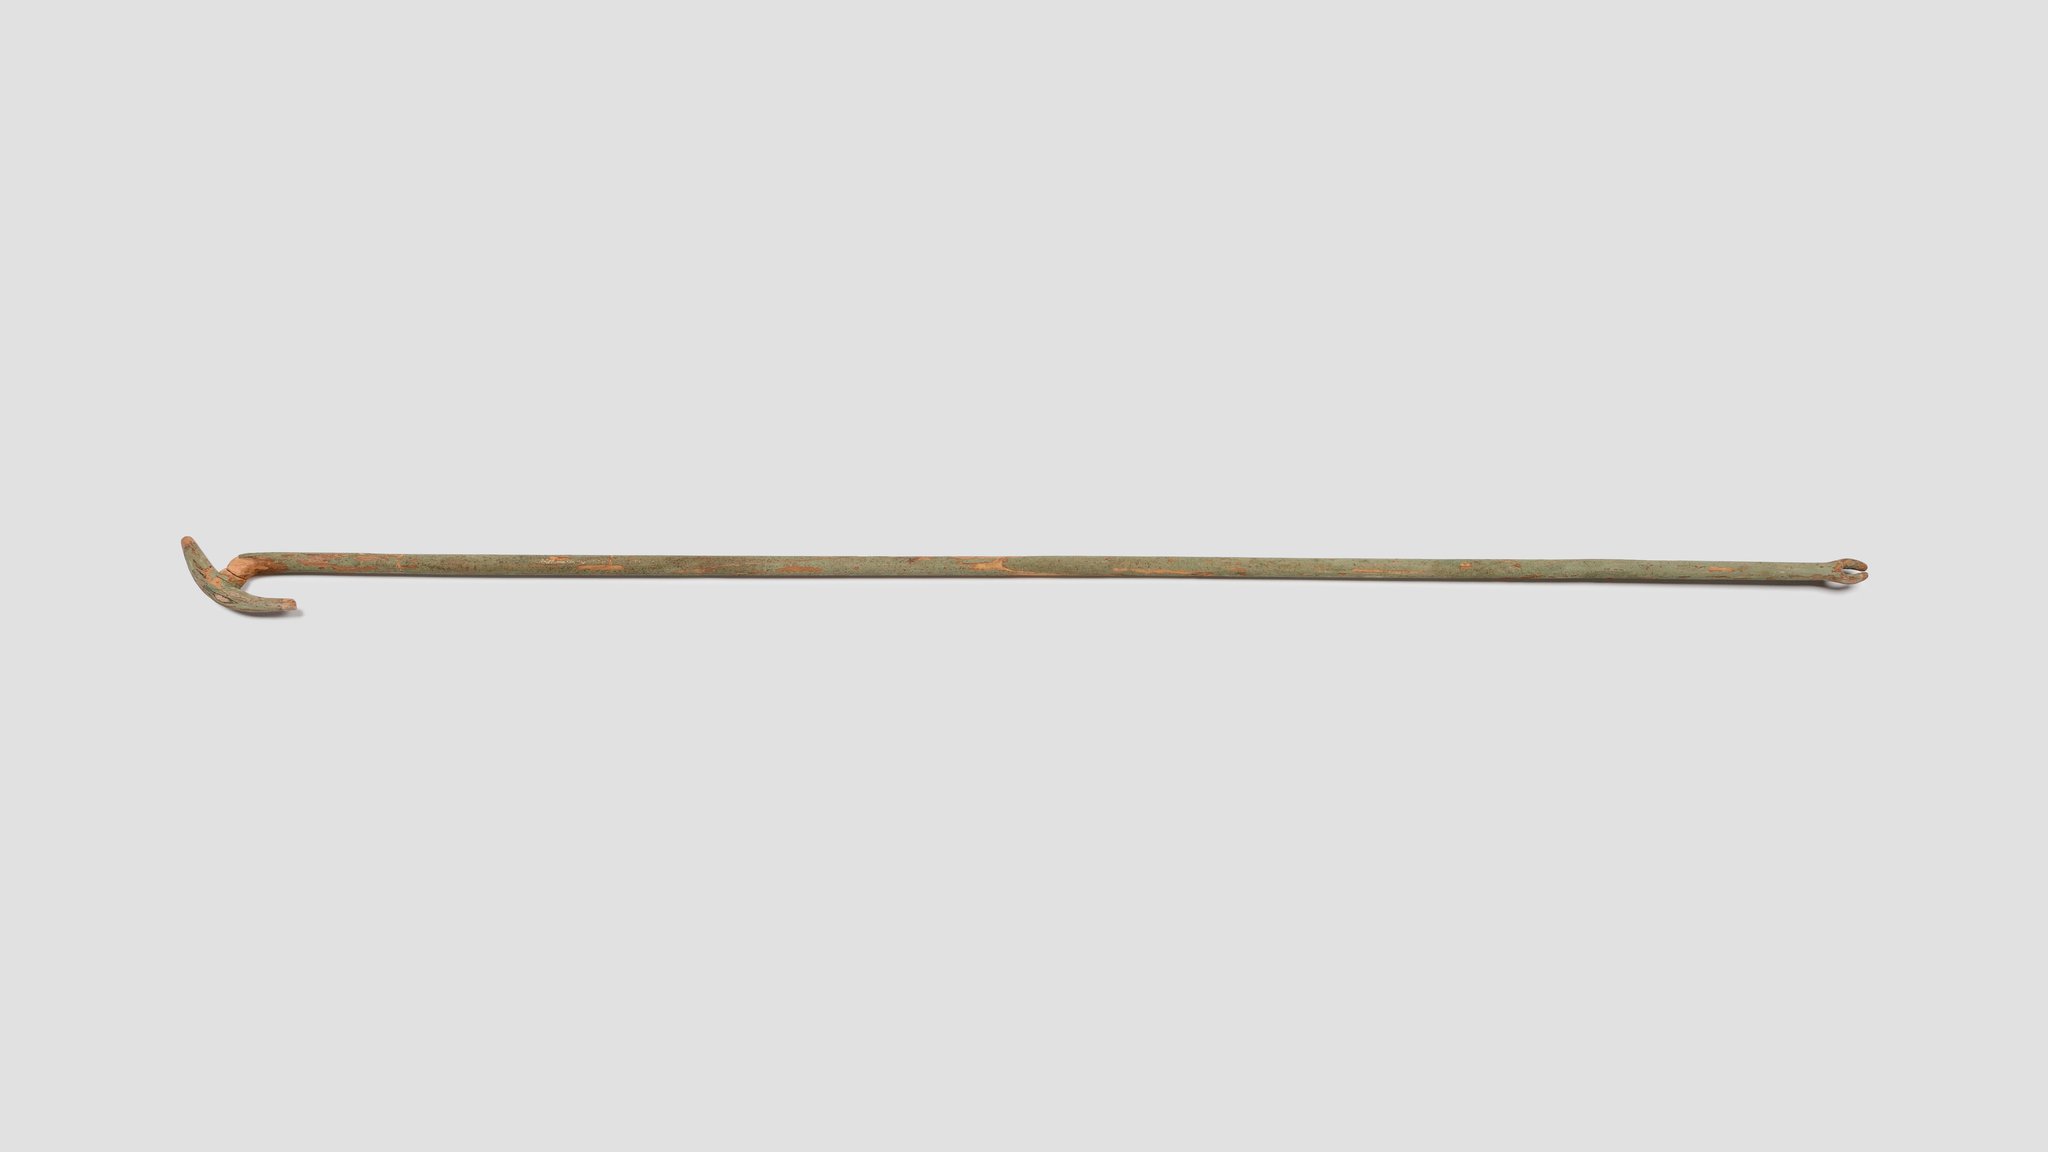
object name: scepter, wa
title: Was scepter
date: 1981-1802 BCE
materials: wood